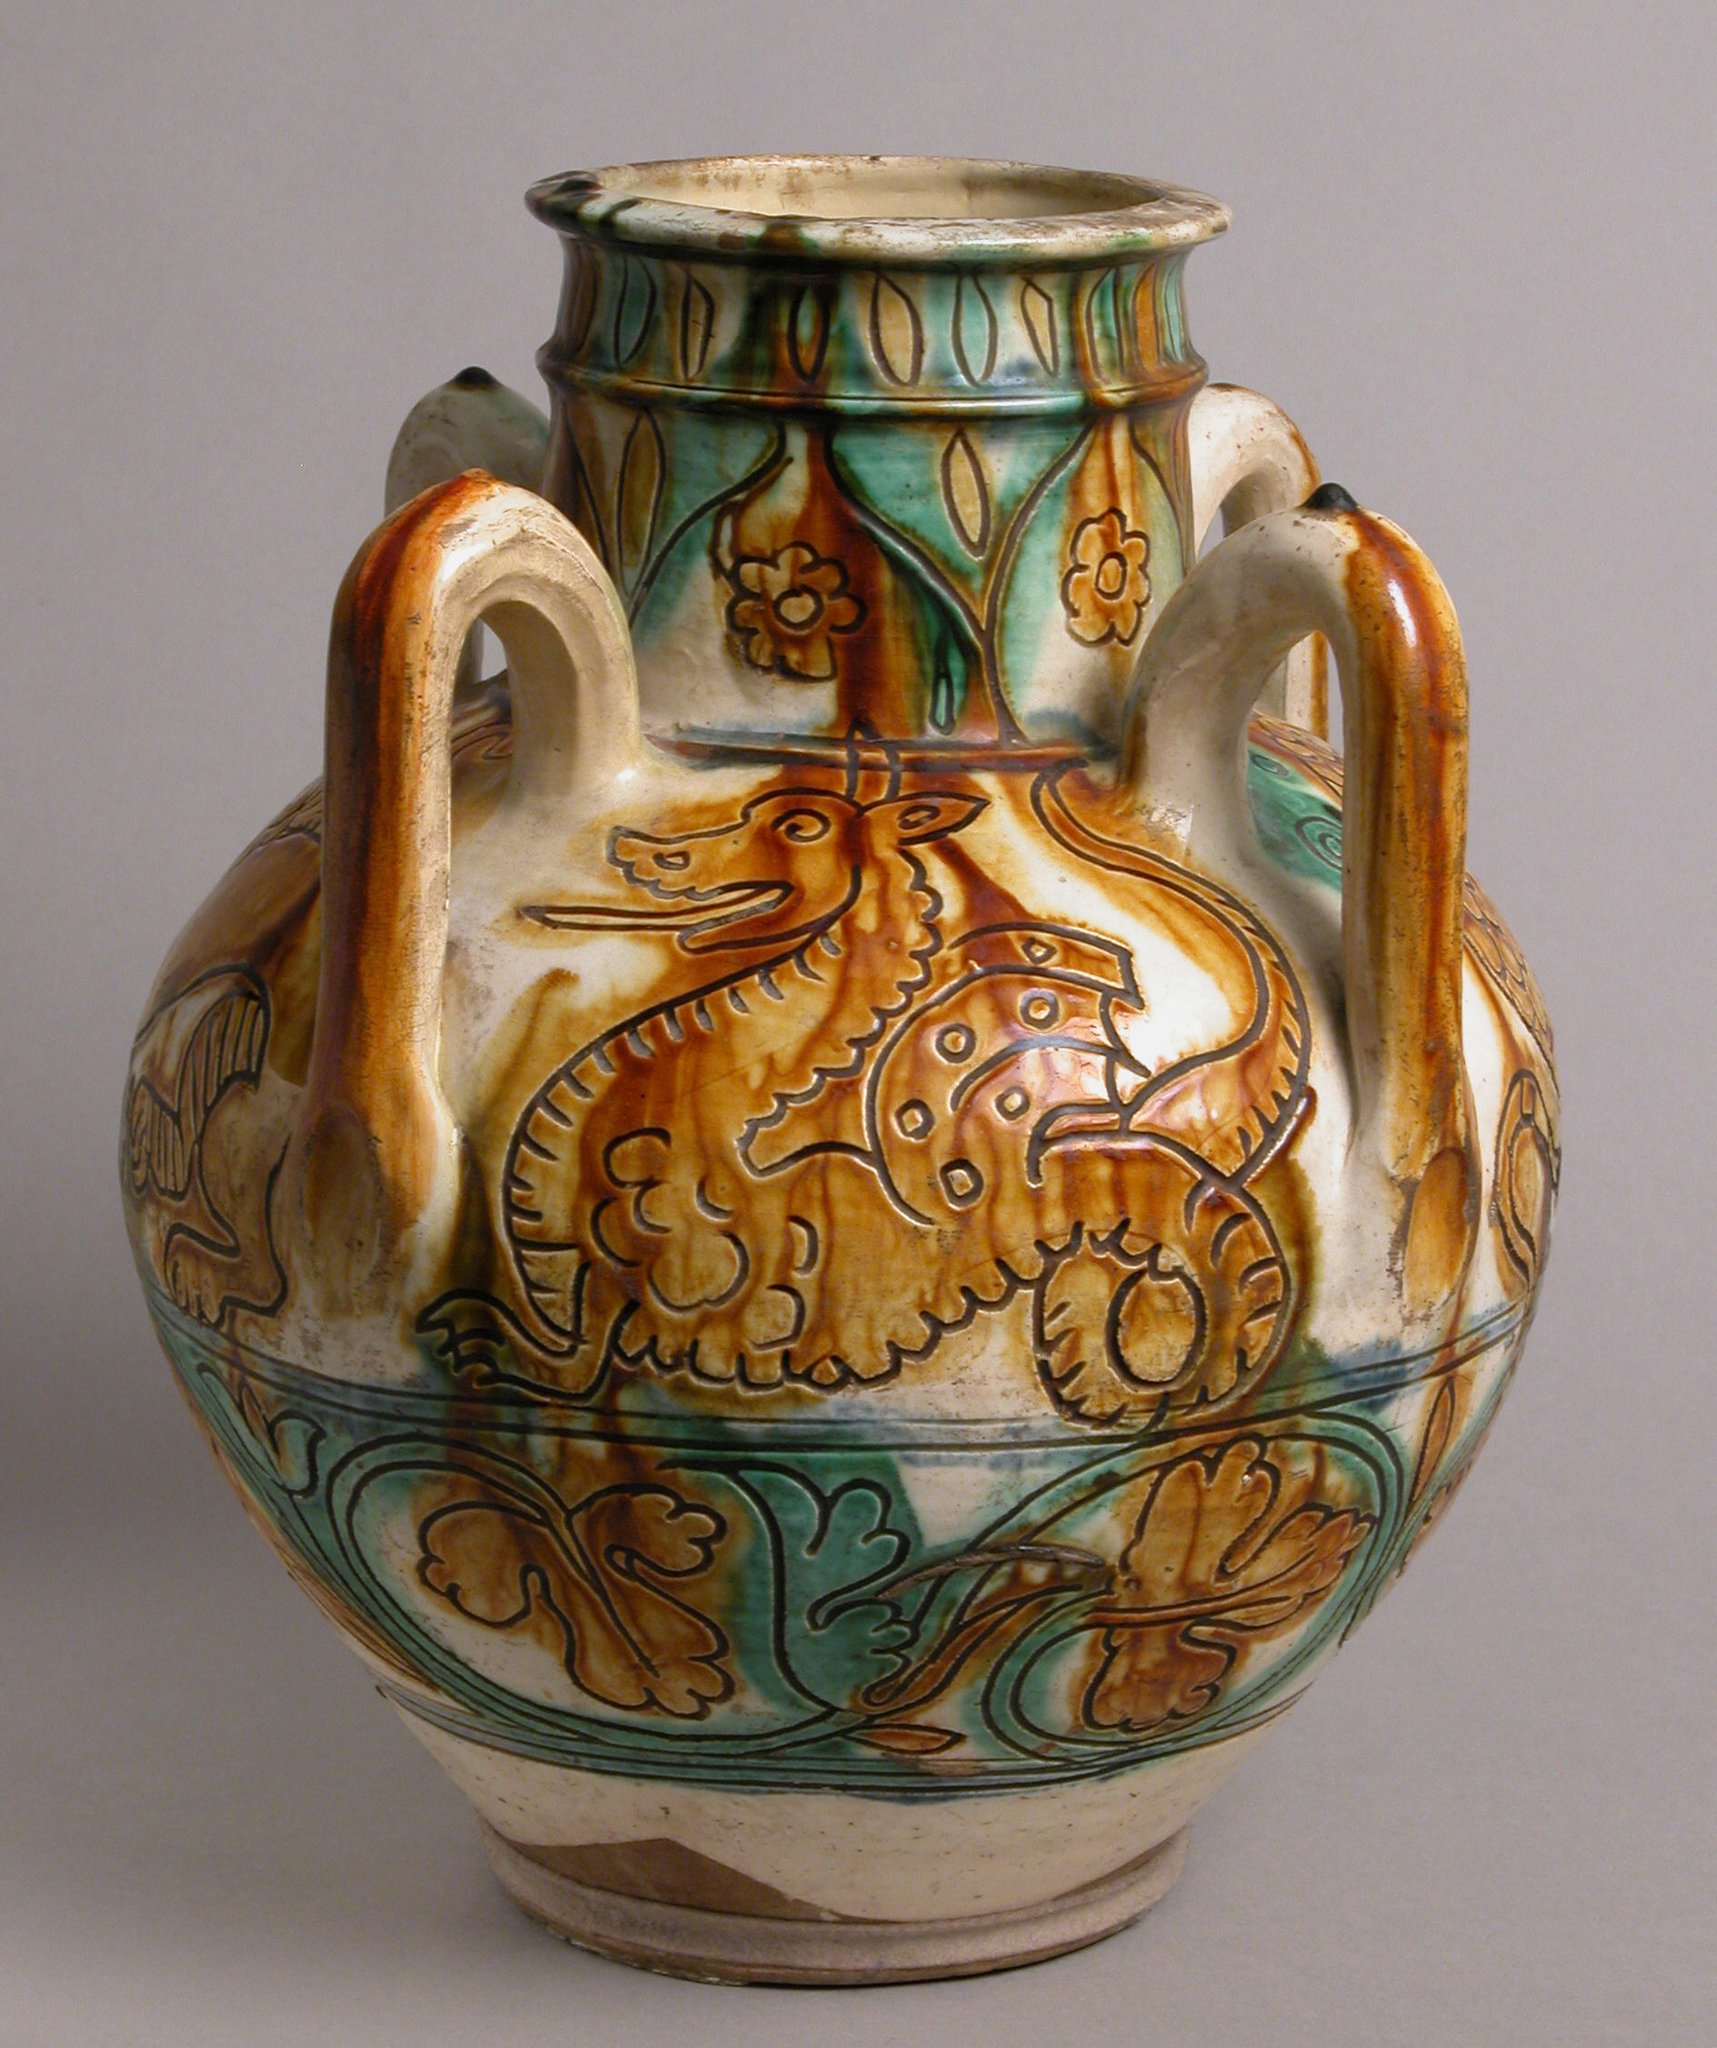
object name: vase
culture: italian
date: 1501-1600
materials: earthenware, glaze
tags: dragons